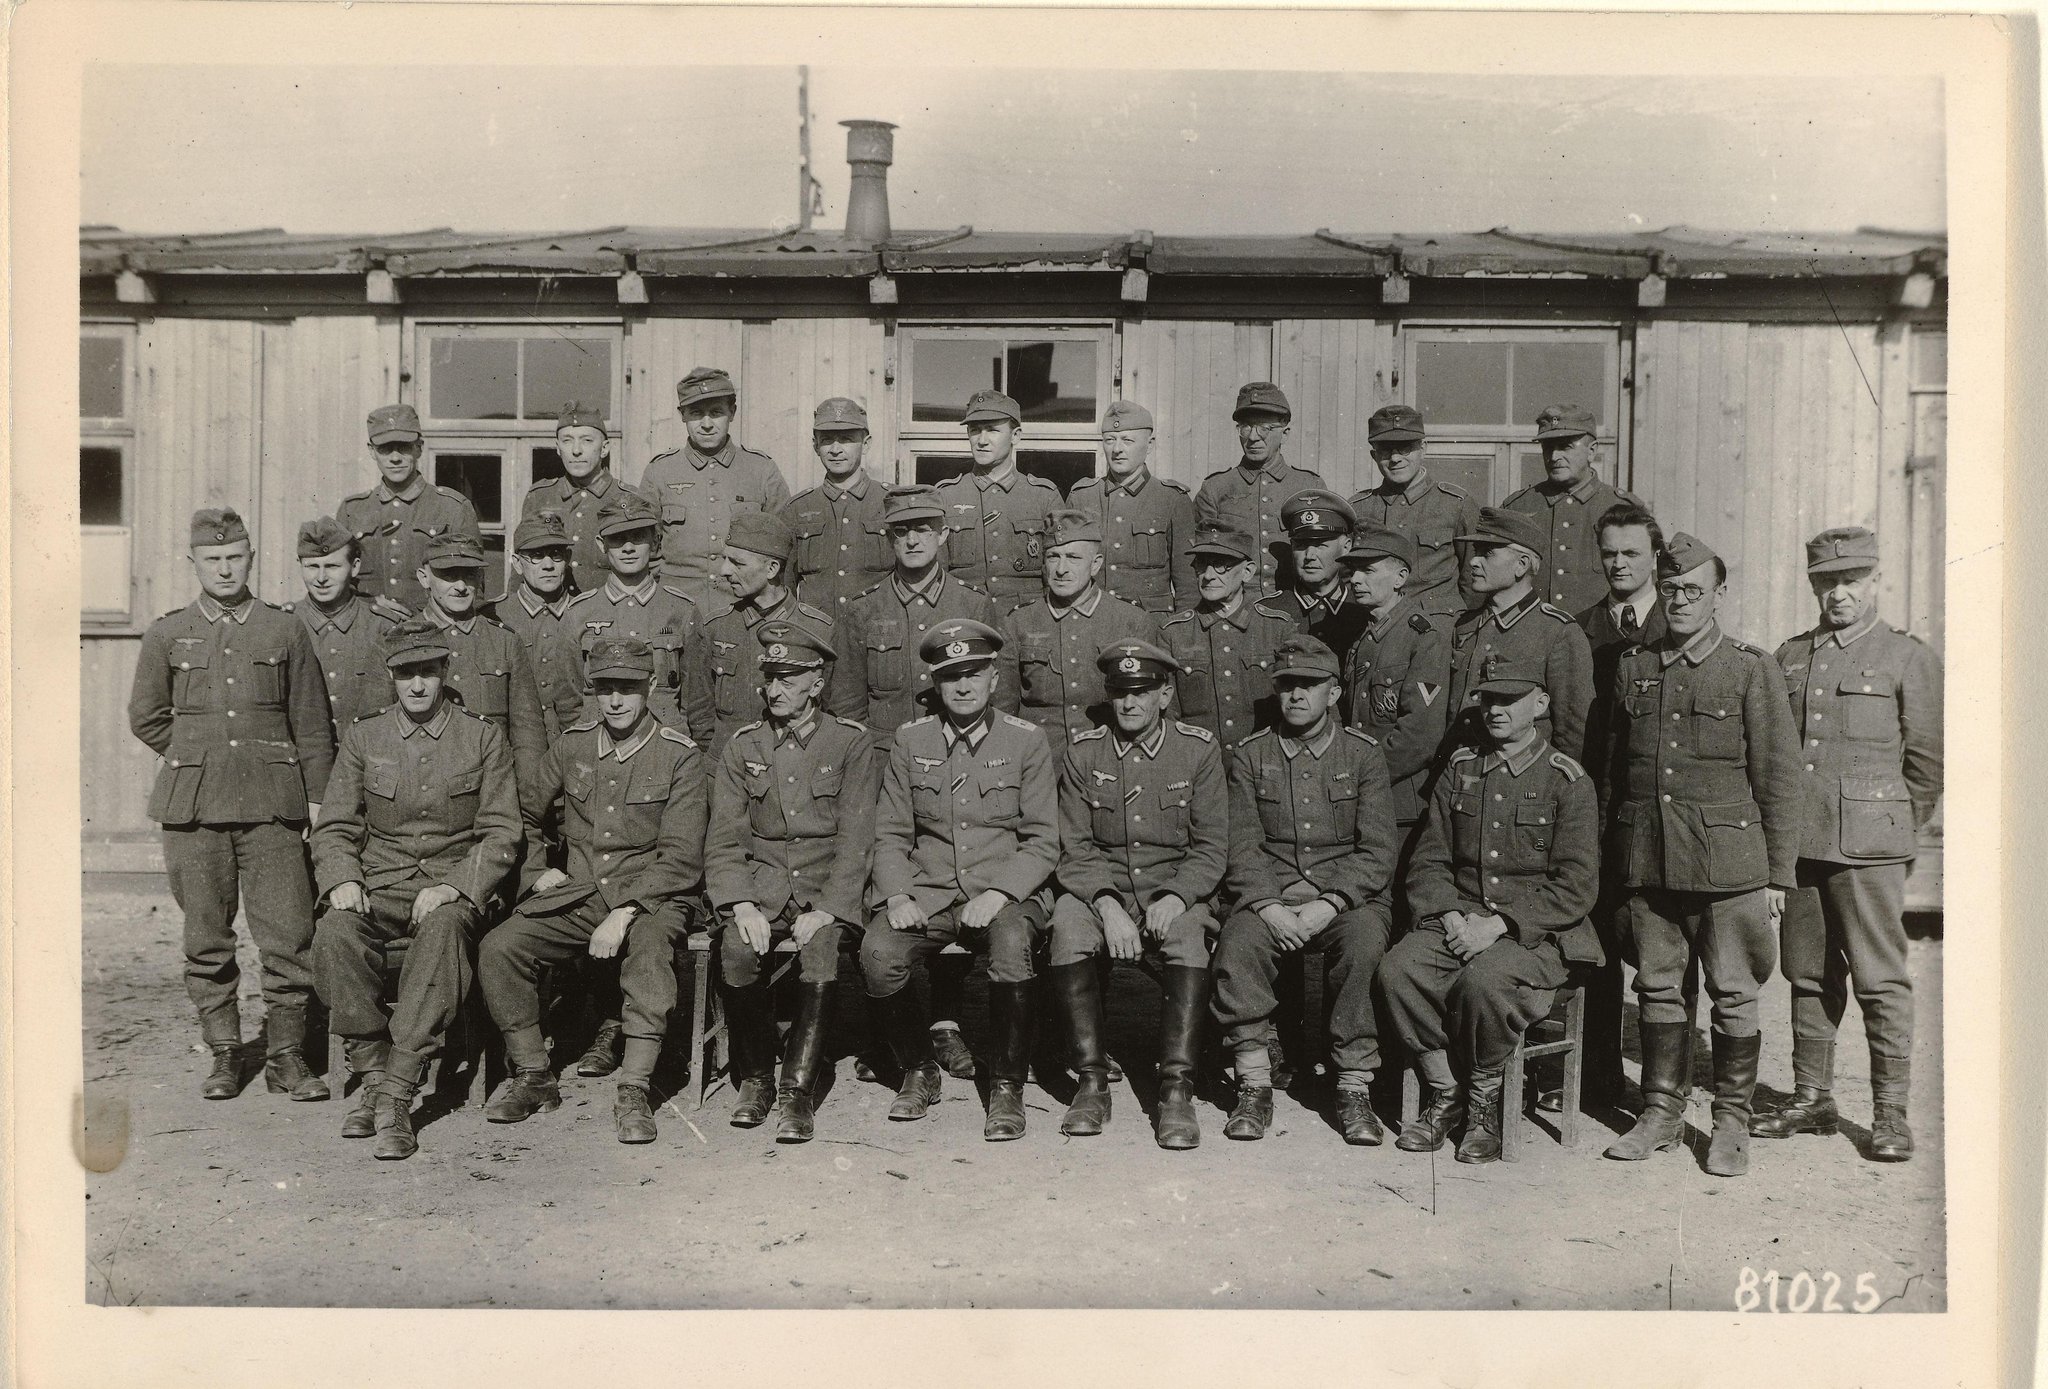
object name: photograph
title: Duitse kampleiding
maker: dick w.b. van maarseveen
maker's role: fotograaf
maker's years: 1905-1990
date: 1943-1945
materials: photographic support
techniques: gelatin silver print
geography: muhlberg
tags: the hague, dick w.b. van maarseveen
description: Groepsfoto van de Duitse bewakers en leiding van Kamp Mühlberg. Onderdeel van een groep foto's gemaakt door Dick van Maarseveen in het Duitse krijgsgevangenenkamp Stalag IV B in Mühlberg in de periode 1943-1945.